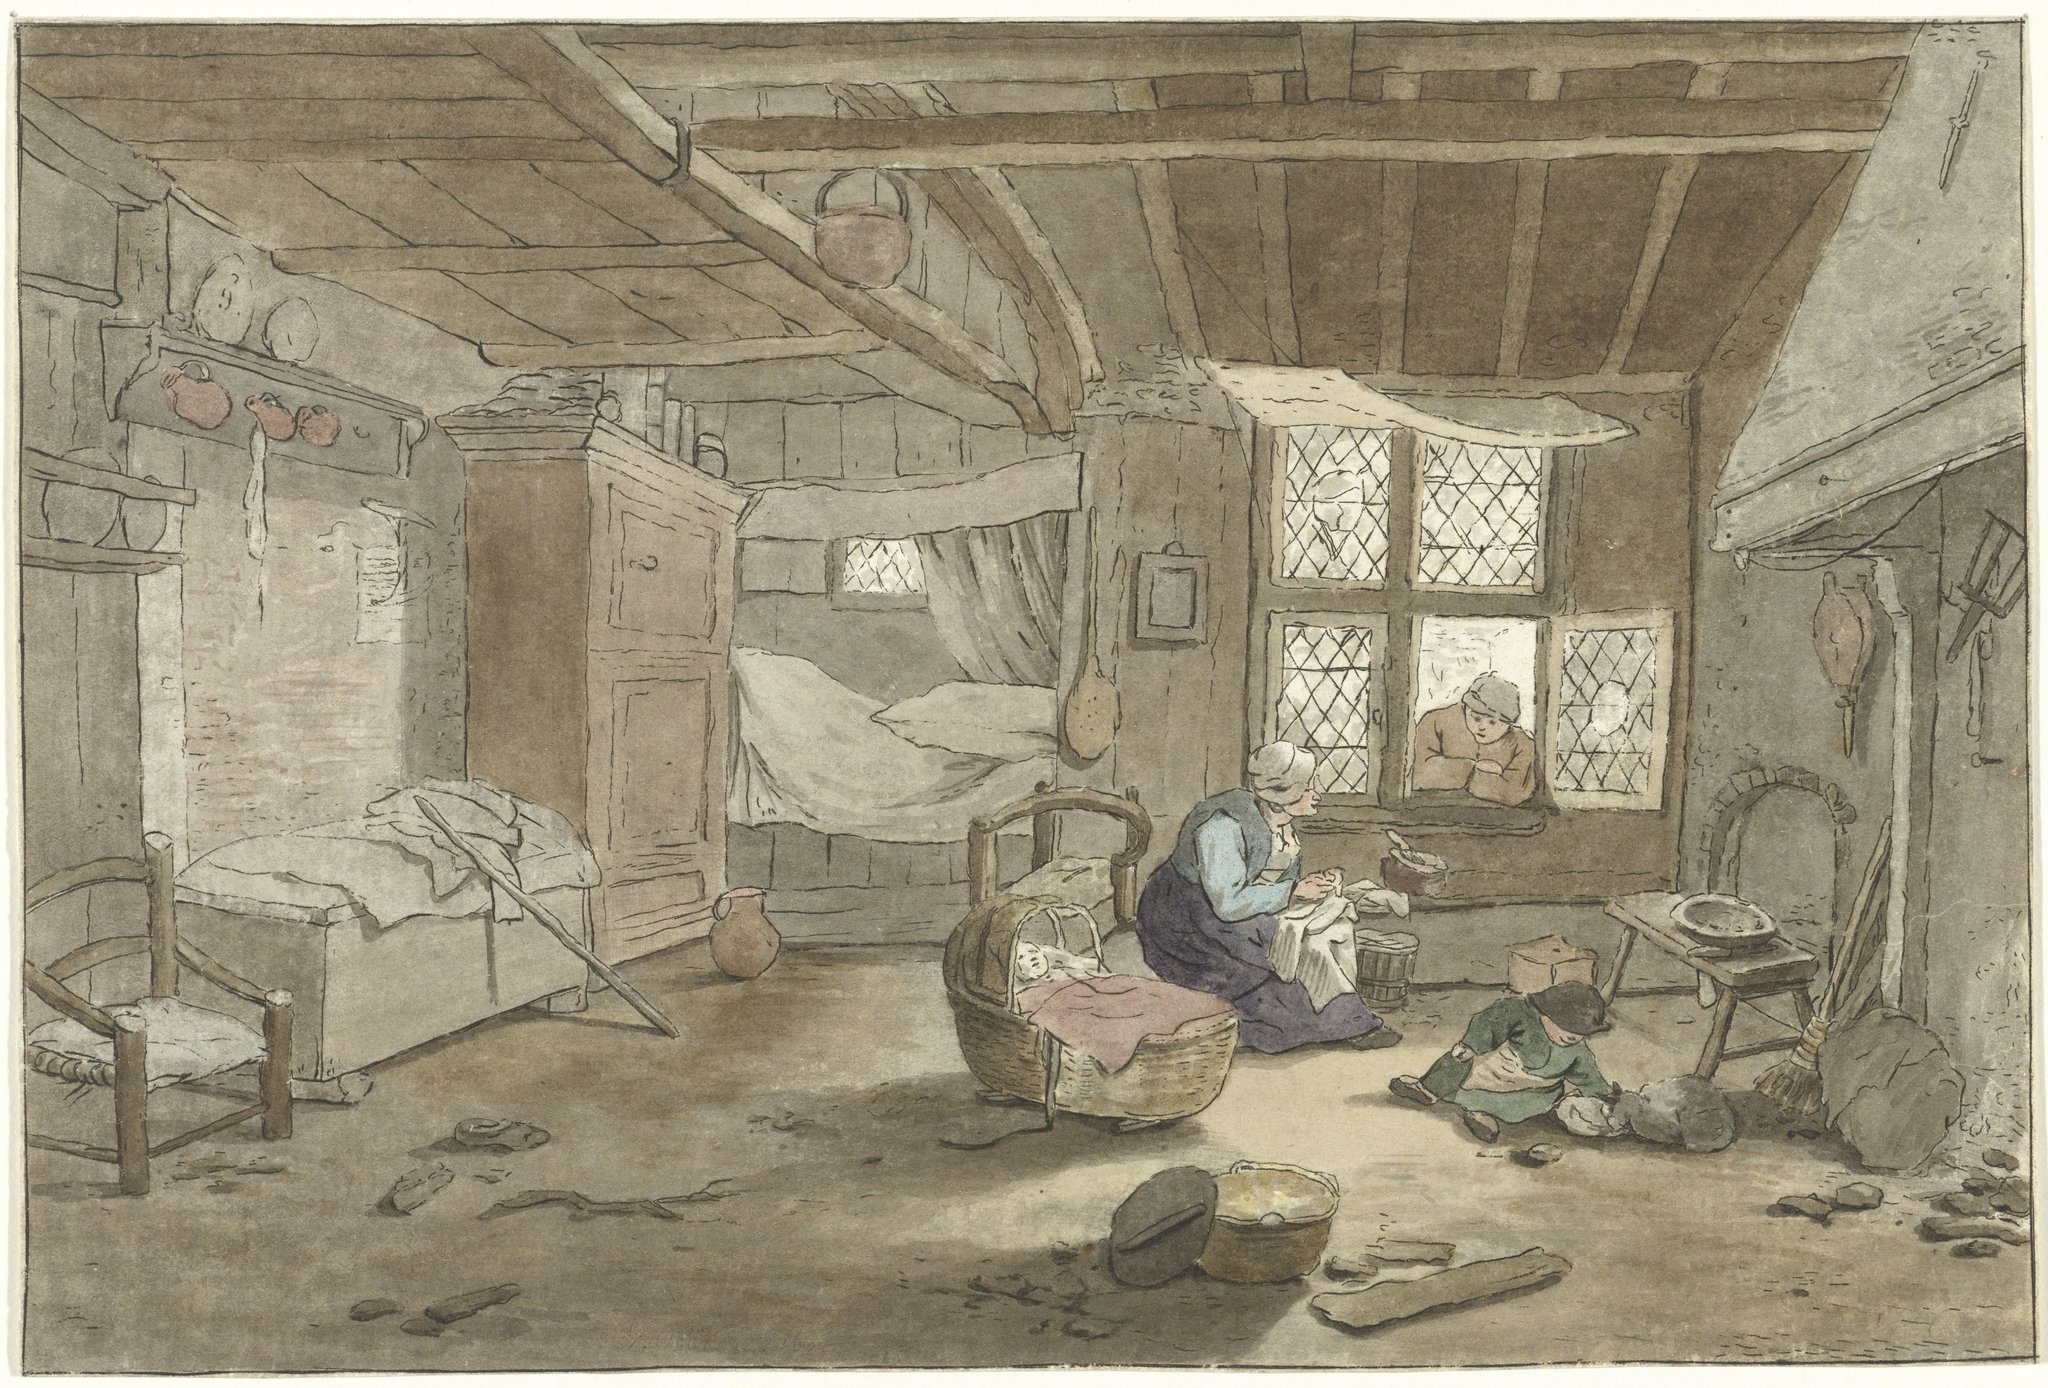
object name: print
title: Interieur met vrouw bij wieg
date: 1767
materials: paper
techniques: hand coloring, roulette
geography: amsterdam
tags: interior of the house, cradle, crib, human figure at (open) window, seen from inside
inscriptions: collector's mark: Lugt 240, inscription: ‘2de proef na de etsdruk / Geoffreerd aan mijn Heer en neef de WEd geb Heer den heer JLvDussen 30 juny 1767. PvA / A v Ostade del: Ploos v Amstel F 1767’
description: Interieur met een vrouw bij een wieg. De vrouw praat met een man, die buiten aan het open raam staat. Bij de haard speelt een kind.